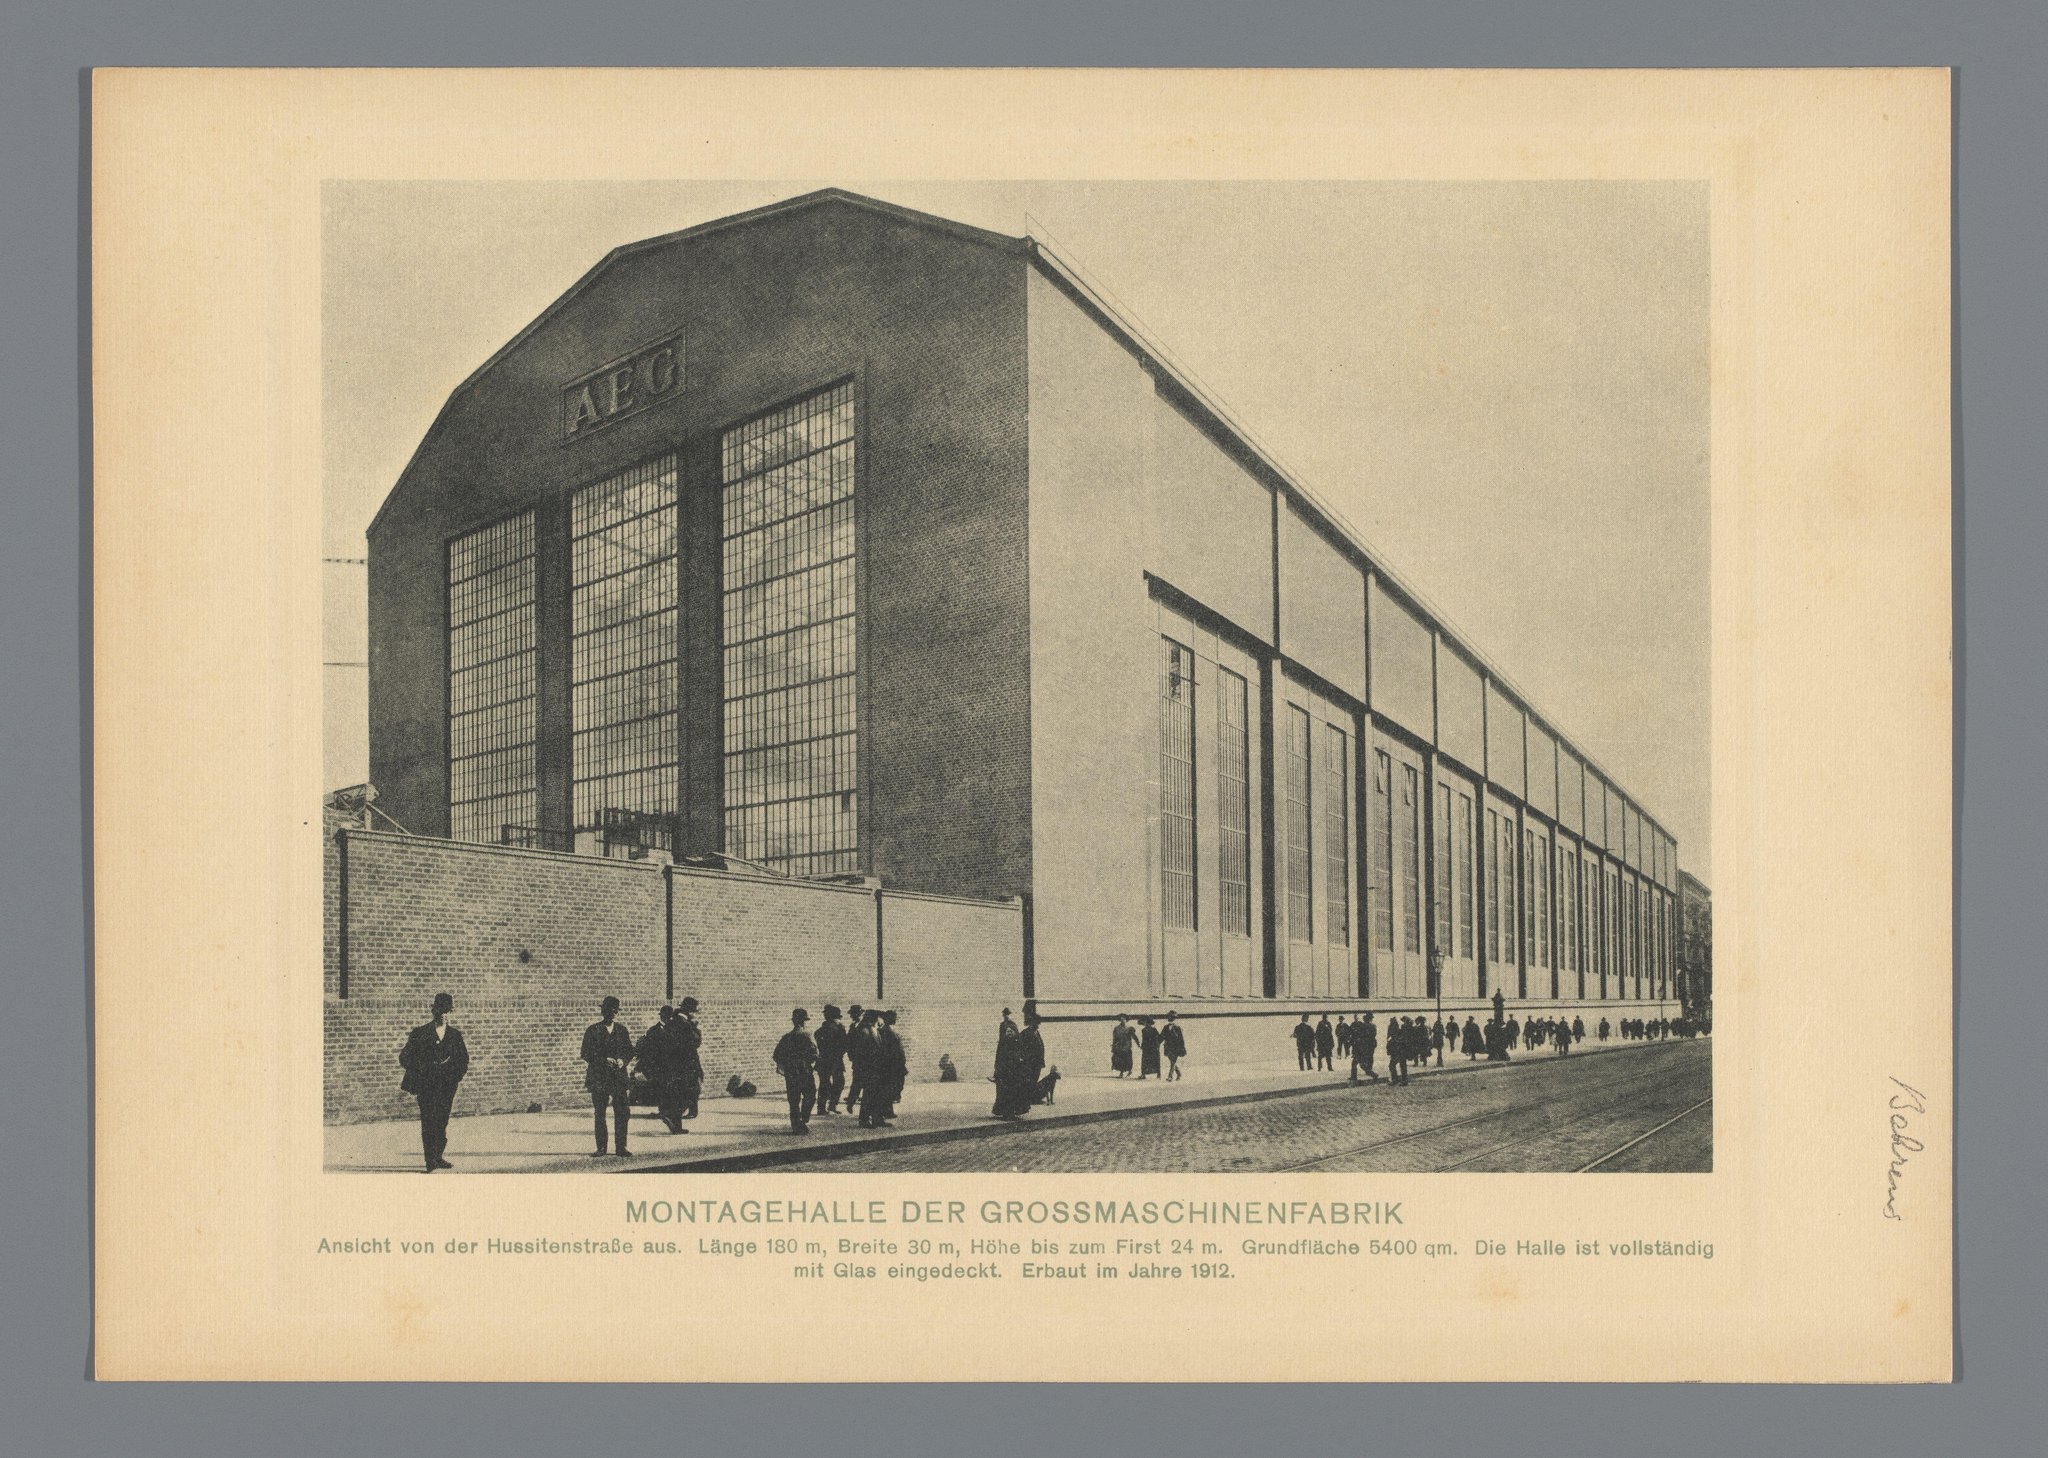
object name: photograph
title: Montagehalle der Grossmaschinenfabrik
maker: Anonymous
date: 1880-1920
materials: photographic support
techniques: autotype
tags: germany